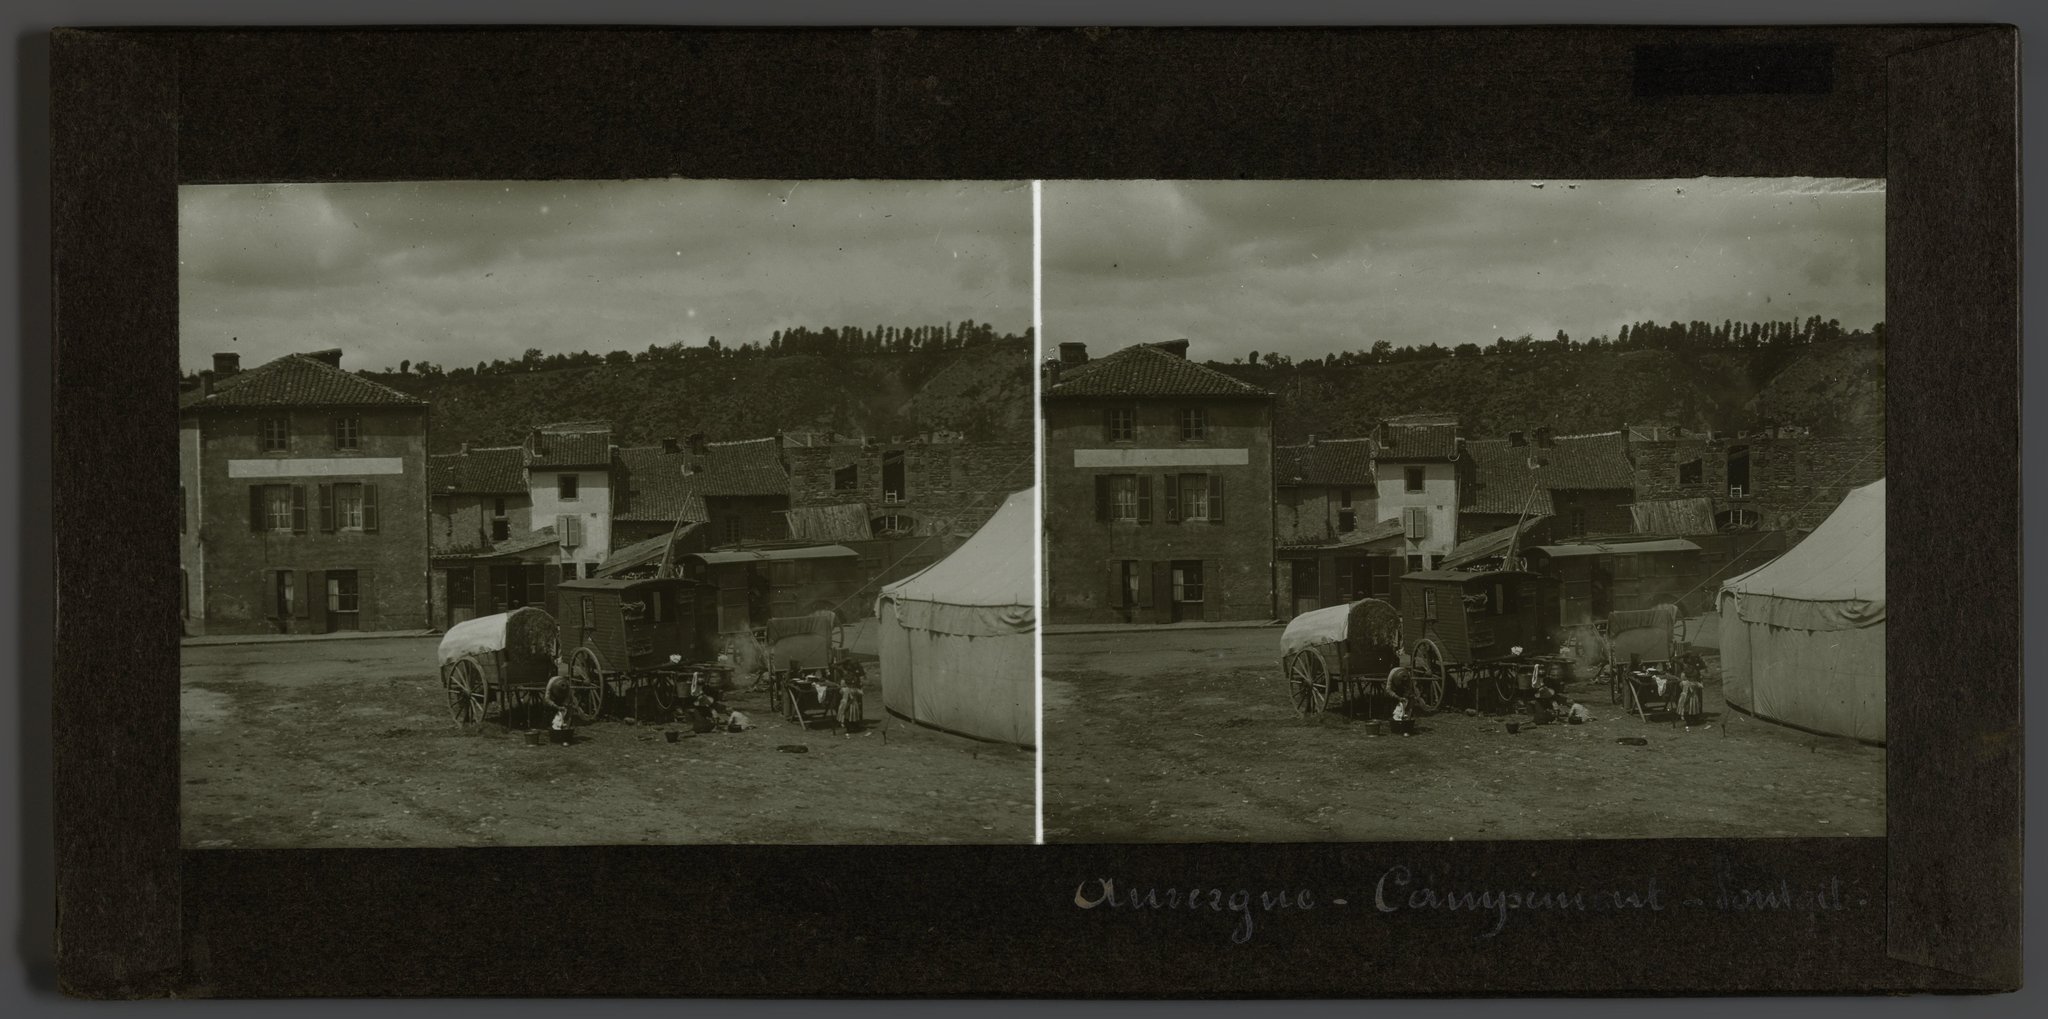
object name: stereoscopic photograph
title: Woonwagenkamp in de Auvergne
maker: Anonymous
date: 1860-1890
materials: glass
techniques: slide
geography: auvergne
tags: caravan-camp